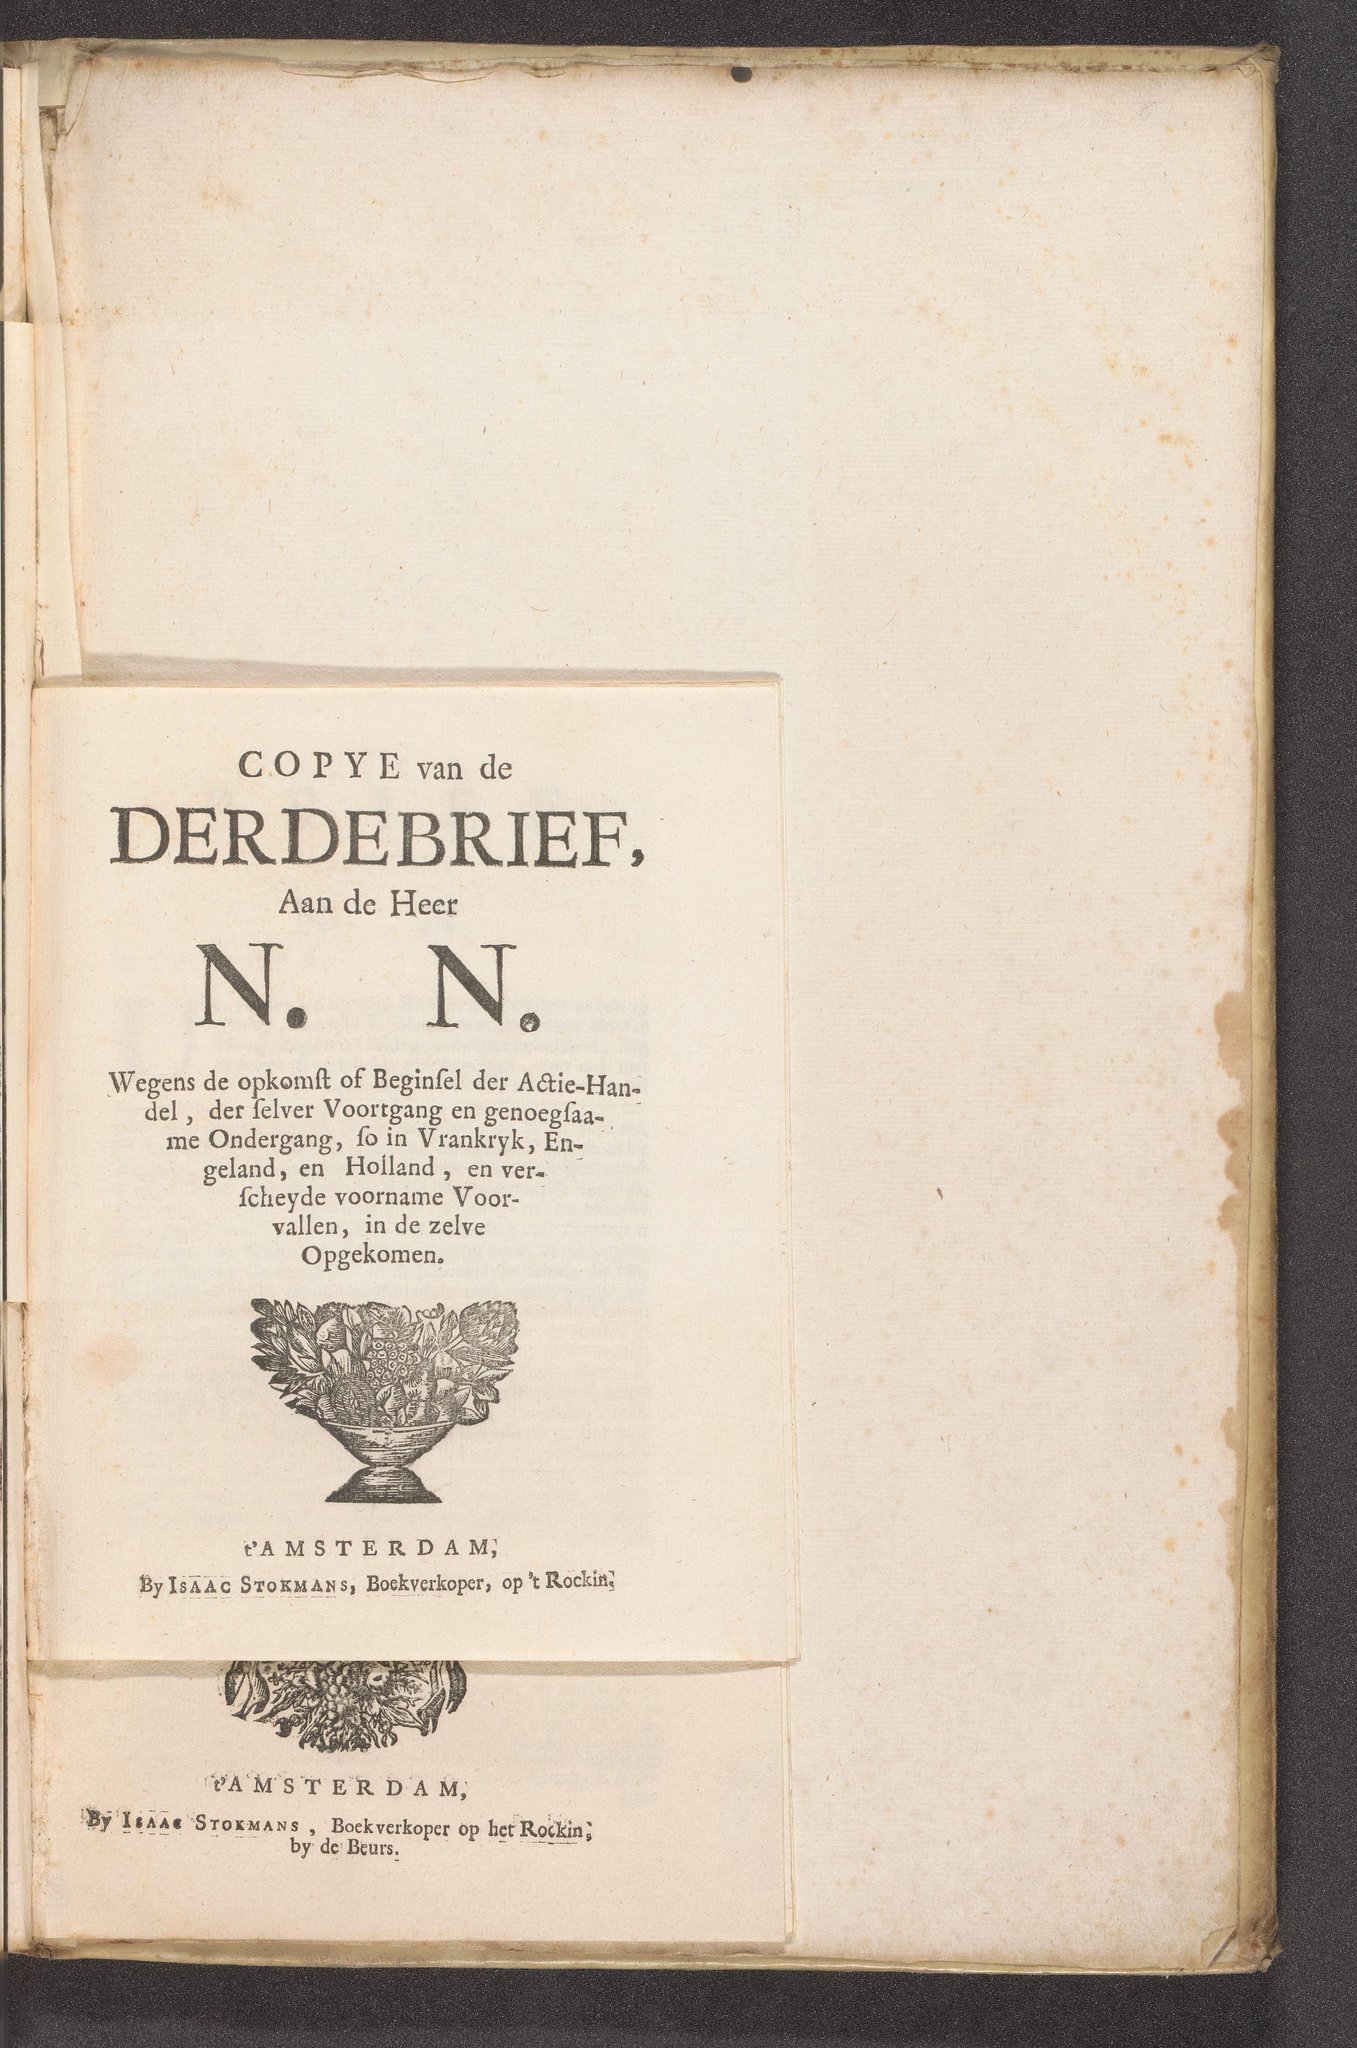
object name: pamphlet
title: Derde brief over het bedrog van de windhandel, 1720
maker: isaac stokmans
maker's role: bookseller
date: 1720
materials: paper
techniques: letterpress printing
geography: amsterdam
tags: windhandel van 1720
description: Pamflet met een derde gedrukte brief van negen bladzijden waarin het bedrog van de windhandel wordt aangetoond, 1720. Pamflet achterin de gebonden eerste uitgave (304 B 10) van Het Groote Tafereel der Dwaasheid met spotprenten op de Windhandel of Actiehandel van 1720.